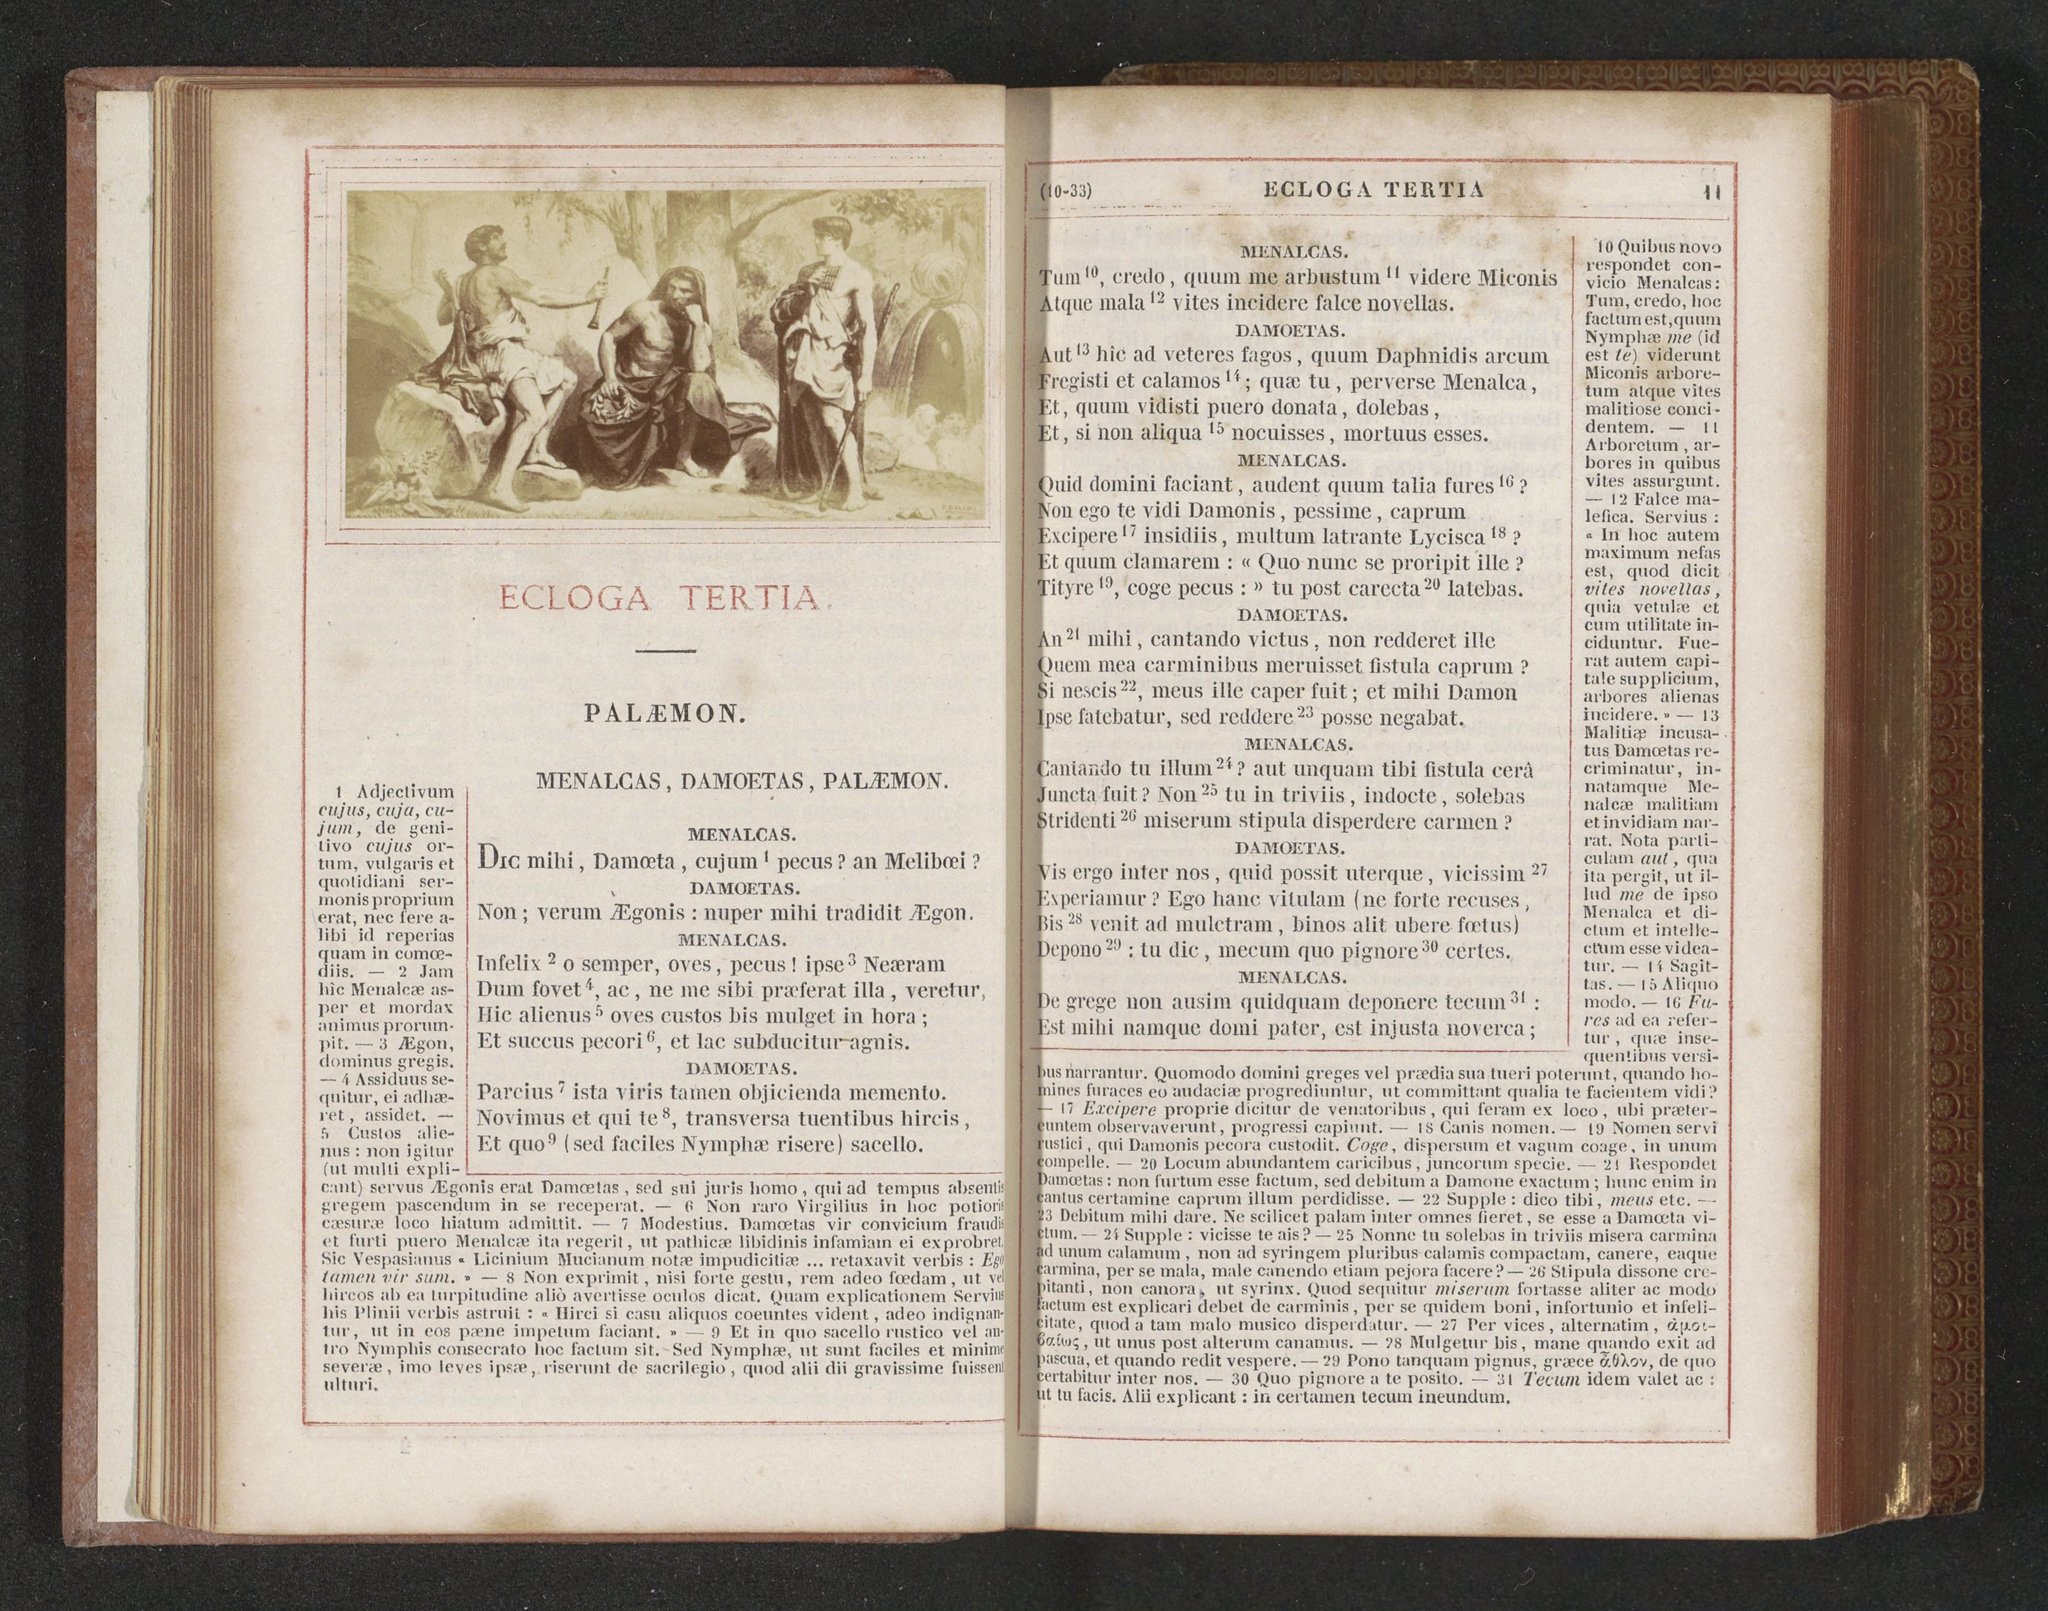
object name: photograph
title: Fotoreproductie van een schilderij, voorstellende Palaemon beoordeelt een zangwedstrijd tussen Menalcas en Damaetas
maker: Anonymous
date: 1850-1858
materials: photographic support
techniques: albumen print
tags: musical instruments; group of musical instruments, competition, art contest, (story of) palaemon